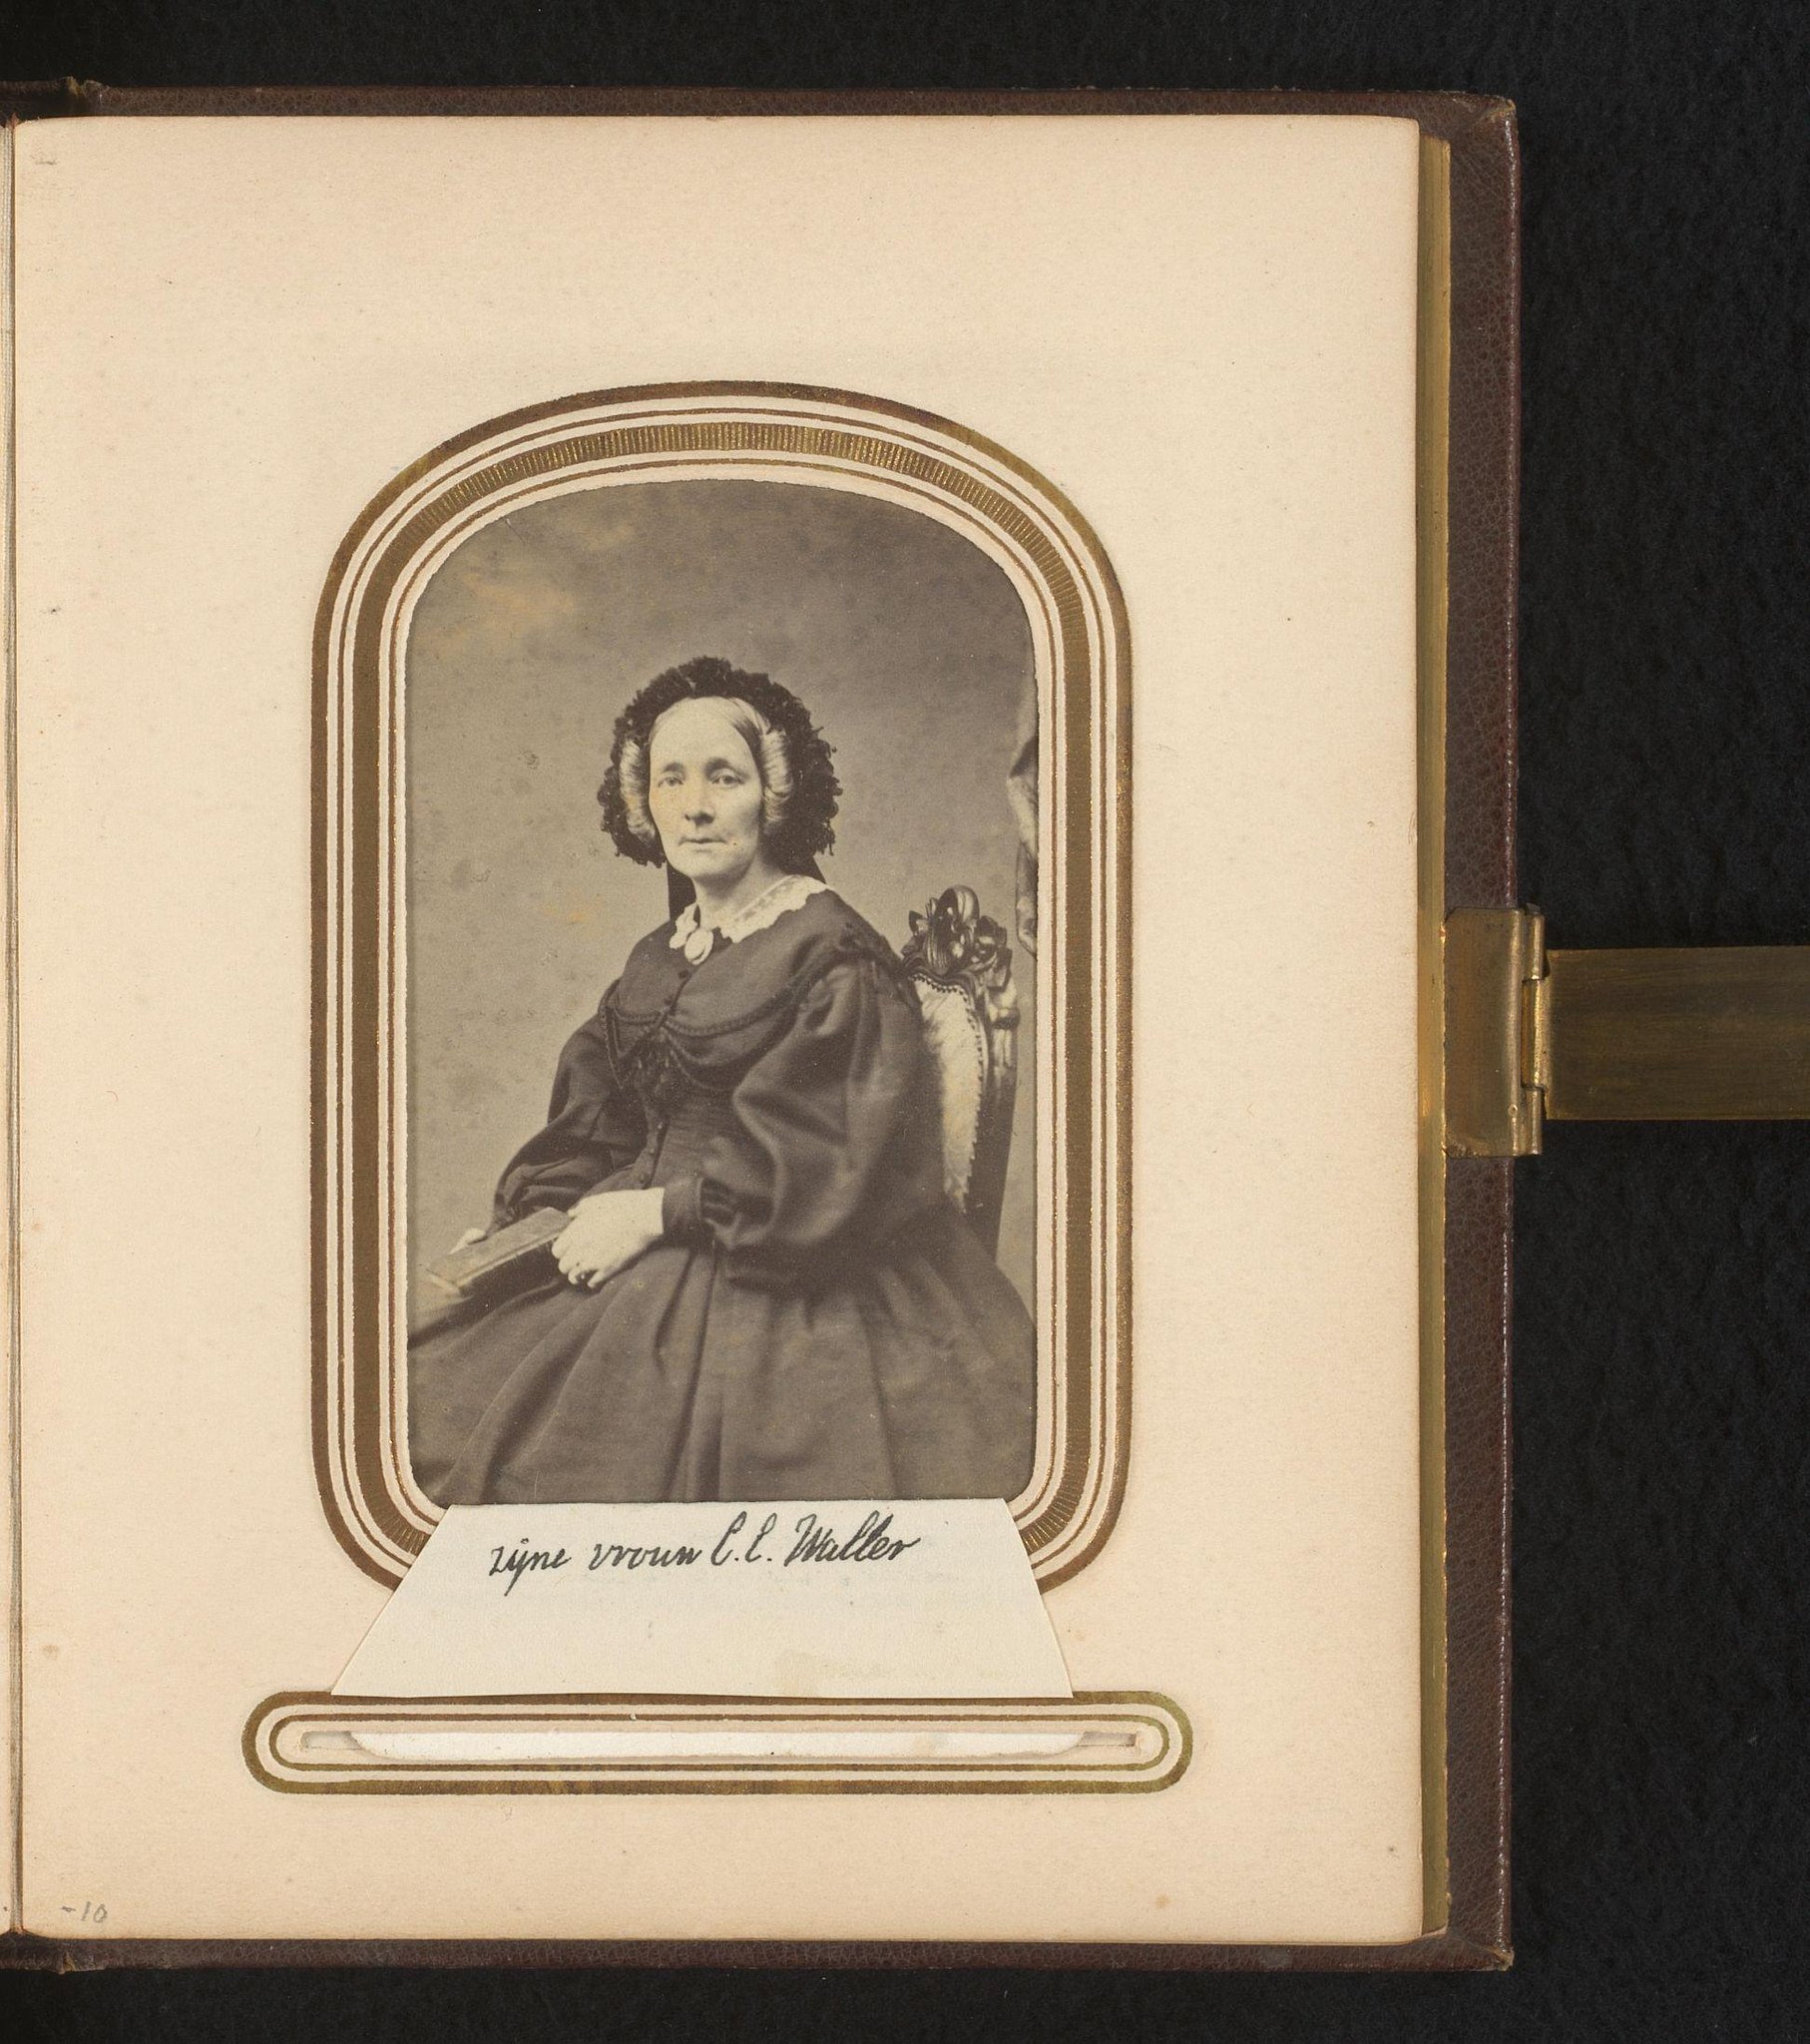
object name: album leaf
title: Zijne vrouw C.E. Waller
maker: heinrich löwenstam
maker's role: painter, print maker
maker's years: 1815-1887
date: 1868-1879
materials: cardboard, paper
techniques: albumen print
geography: amsterdam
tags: amsterdam, historical persons - bb - woman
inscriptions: address: ‘AMSTERDAM/ Singel, J J 454.’